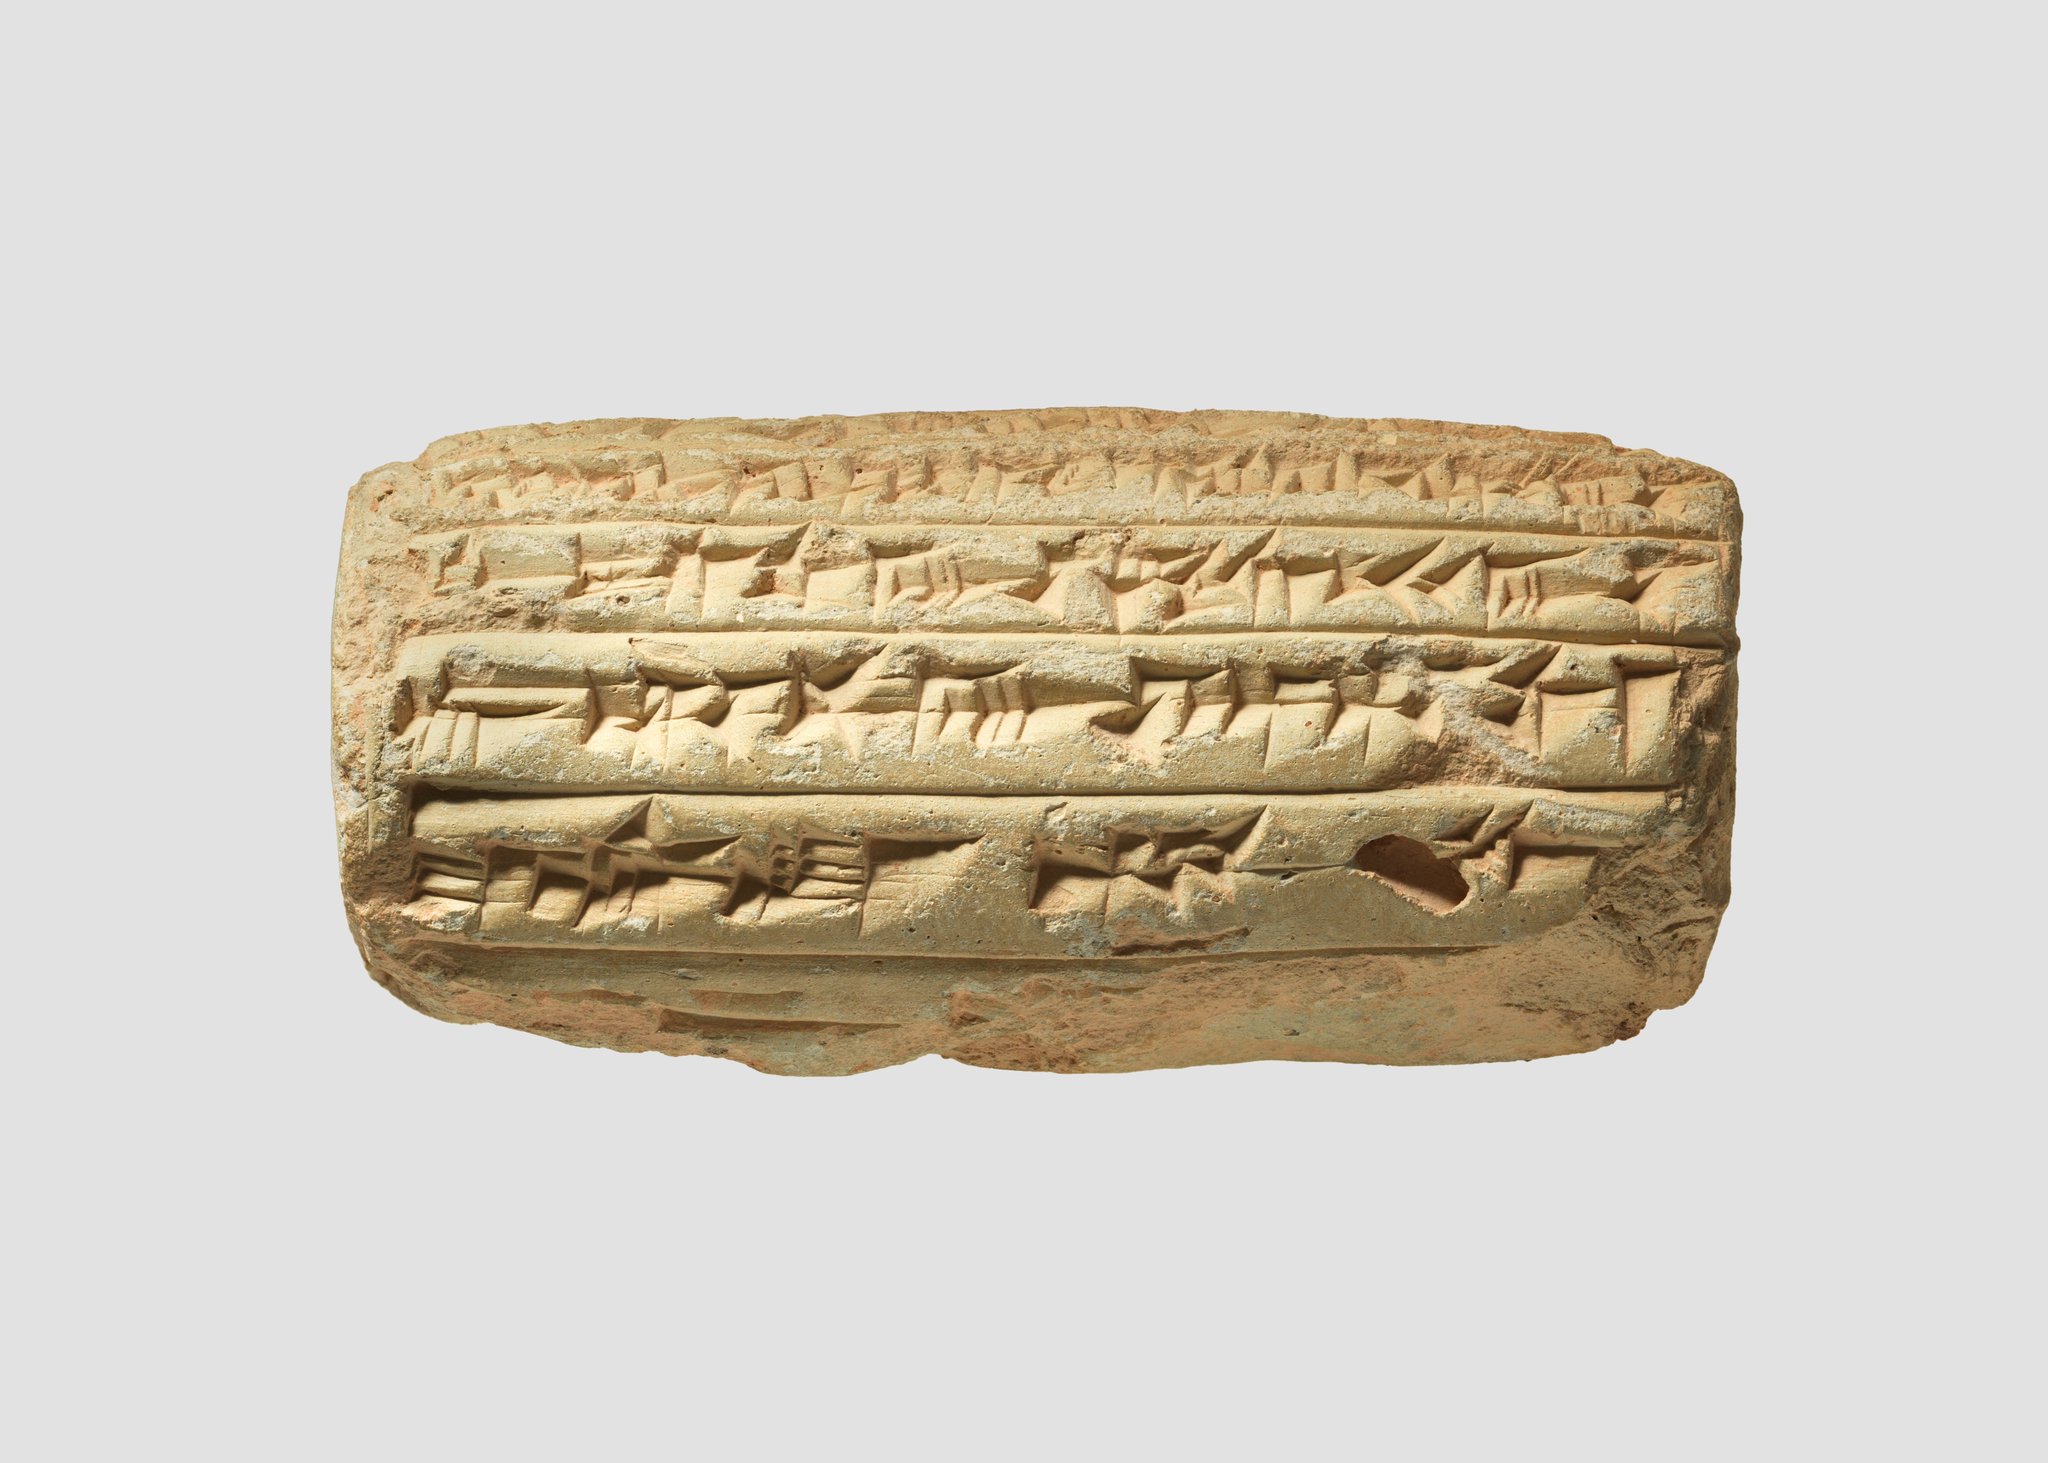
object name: cuneiform cylinder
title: Cuneiform cylinder: inscription of Esarhaddon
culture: assyrian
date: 680-669 BCE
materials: clay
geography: mesopotamia